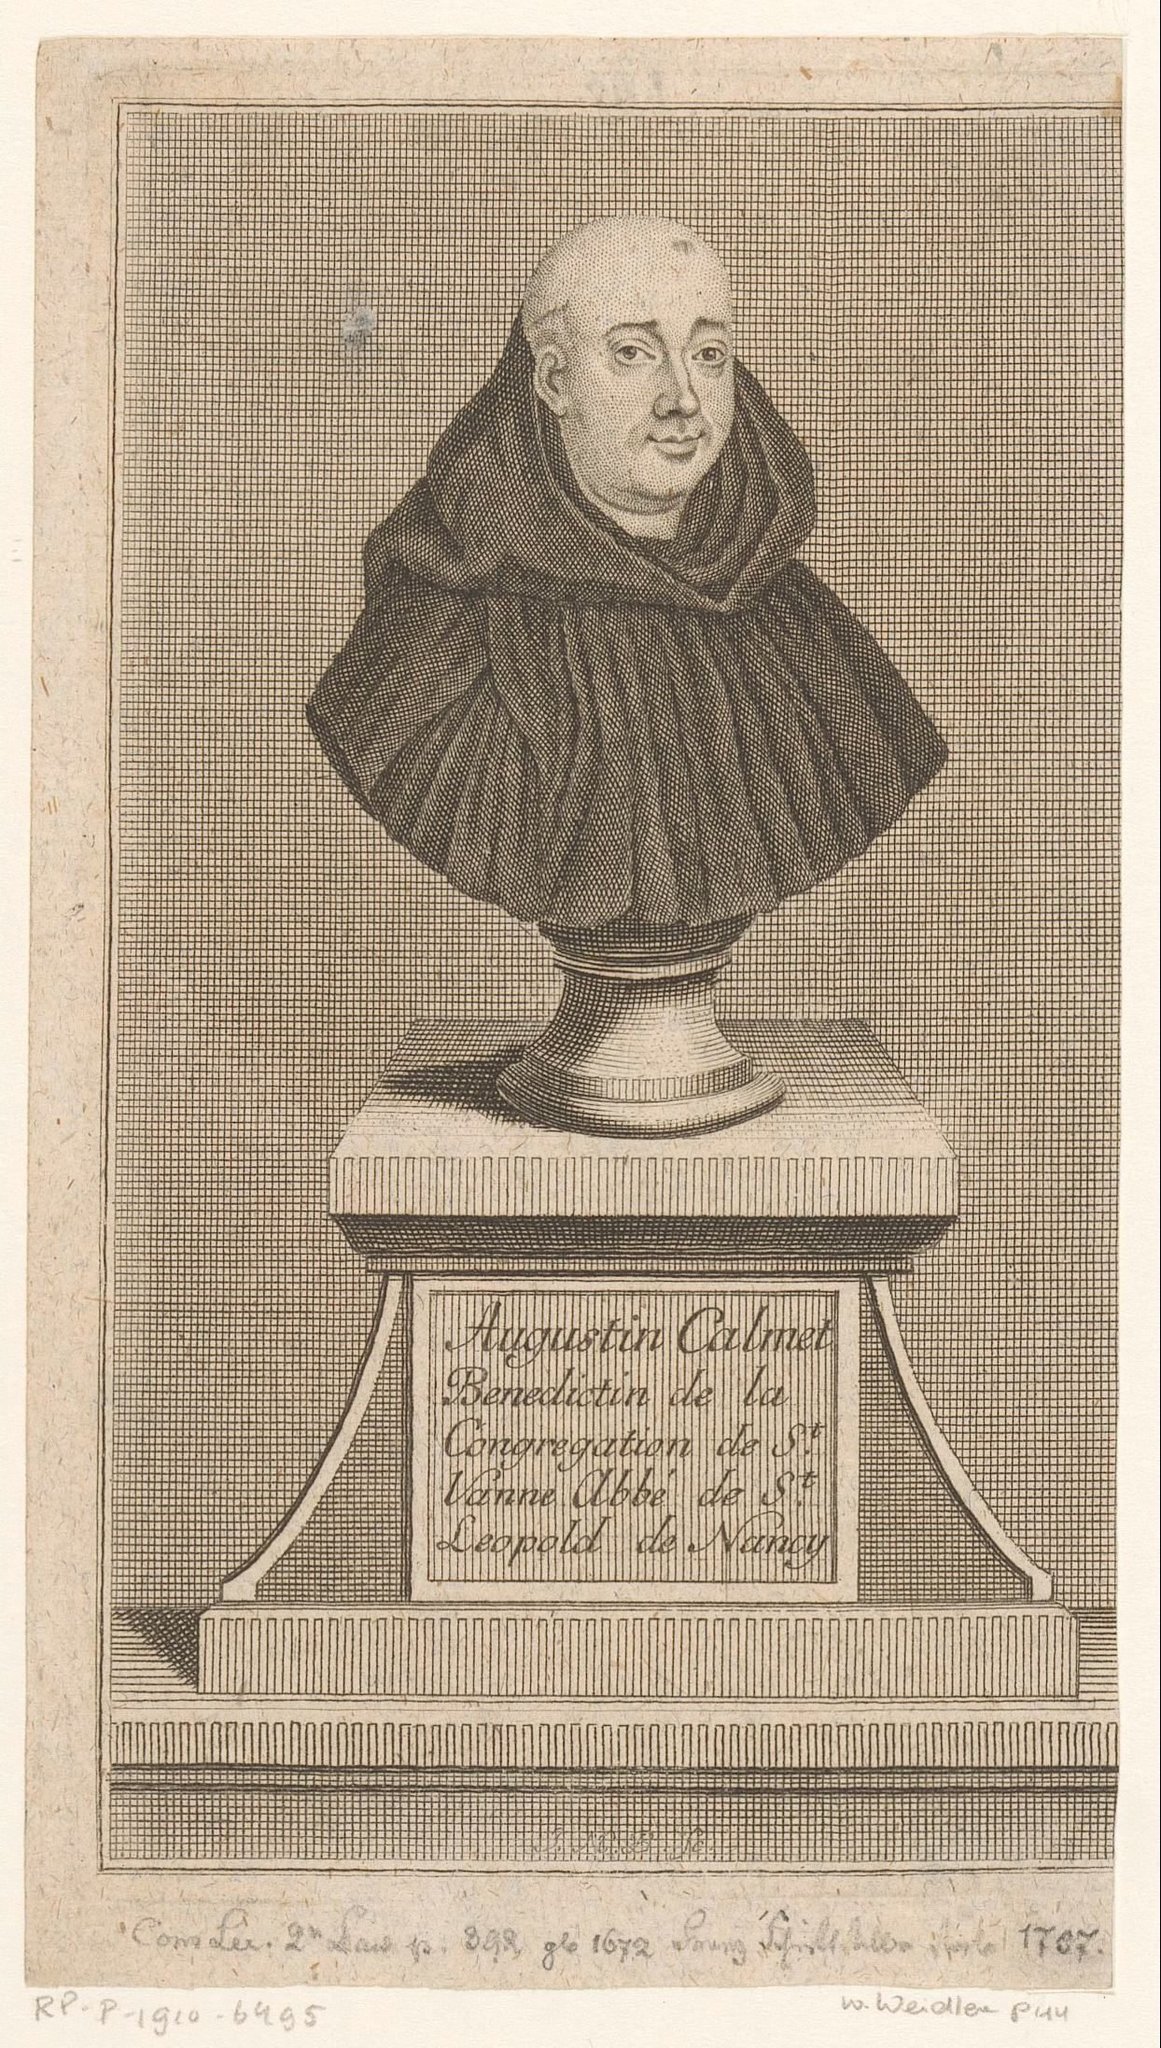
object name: print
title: Portret van Augustin Calmet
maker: johann martin bernigeroth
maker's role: print maker, publisher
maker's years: 1713-1767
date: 1742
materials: paper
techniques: engraving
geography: leipzig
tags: historical persons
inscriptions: collector's mark: Lugt 2228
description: Prent ook gebruikt in: Zuverlässige Nachrichten von dem gegenwärtigen Zustande, Veränderung und Wachsthum der Wissenschaften. dl. 25. Leipzig: Johann Friedrich Gleditsch, 1742.